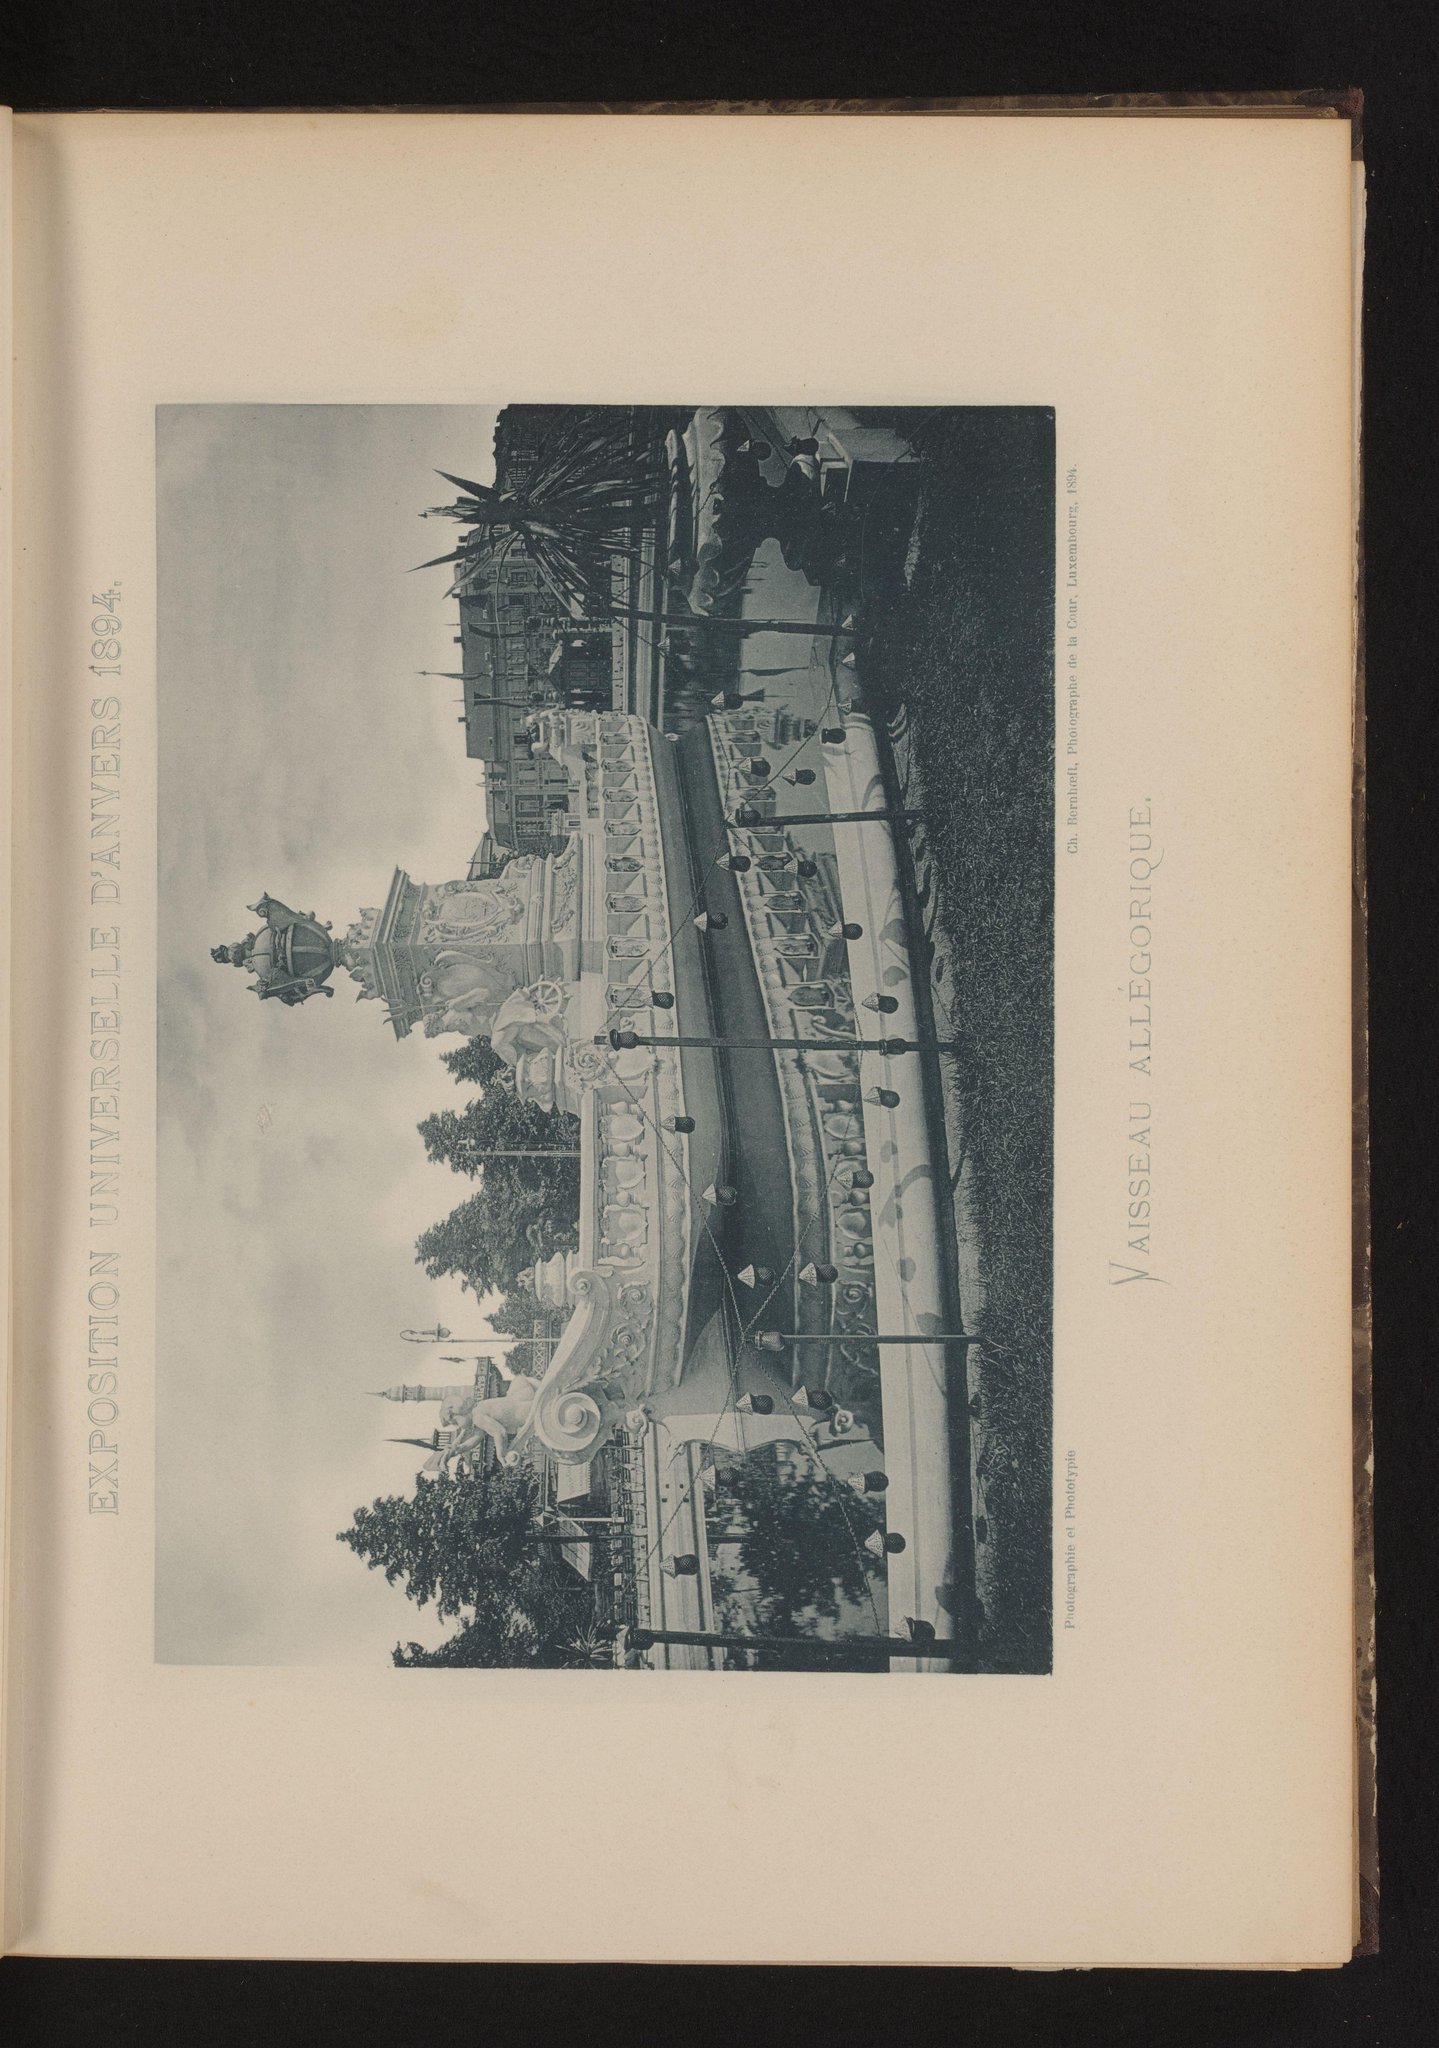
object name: page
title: Exposition Universelle d'Anvers 1894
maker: charles bernhoeft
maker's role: publisher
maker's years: 1859-1933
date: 1894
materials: paper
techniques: photograph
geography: antwerp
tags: world fair, world exhibition, neptune as lord of the sea, steamship, motorship, antwerp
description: Prent op derde ongenummerde pagina na pagina 6.